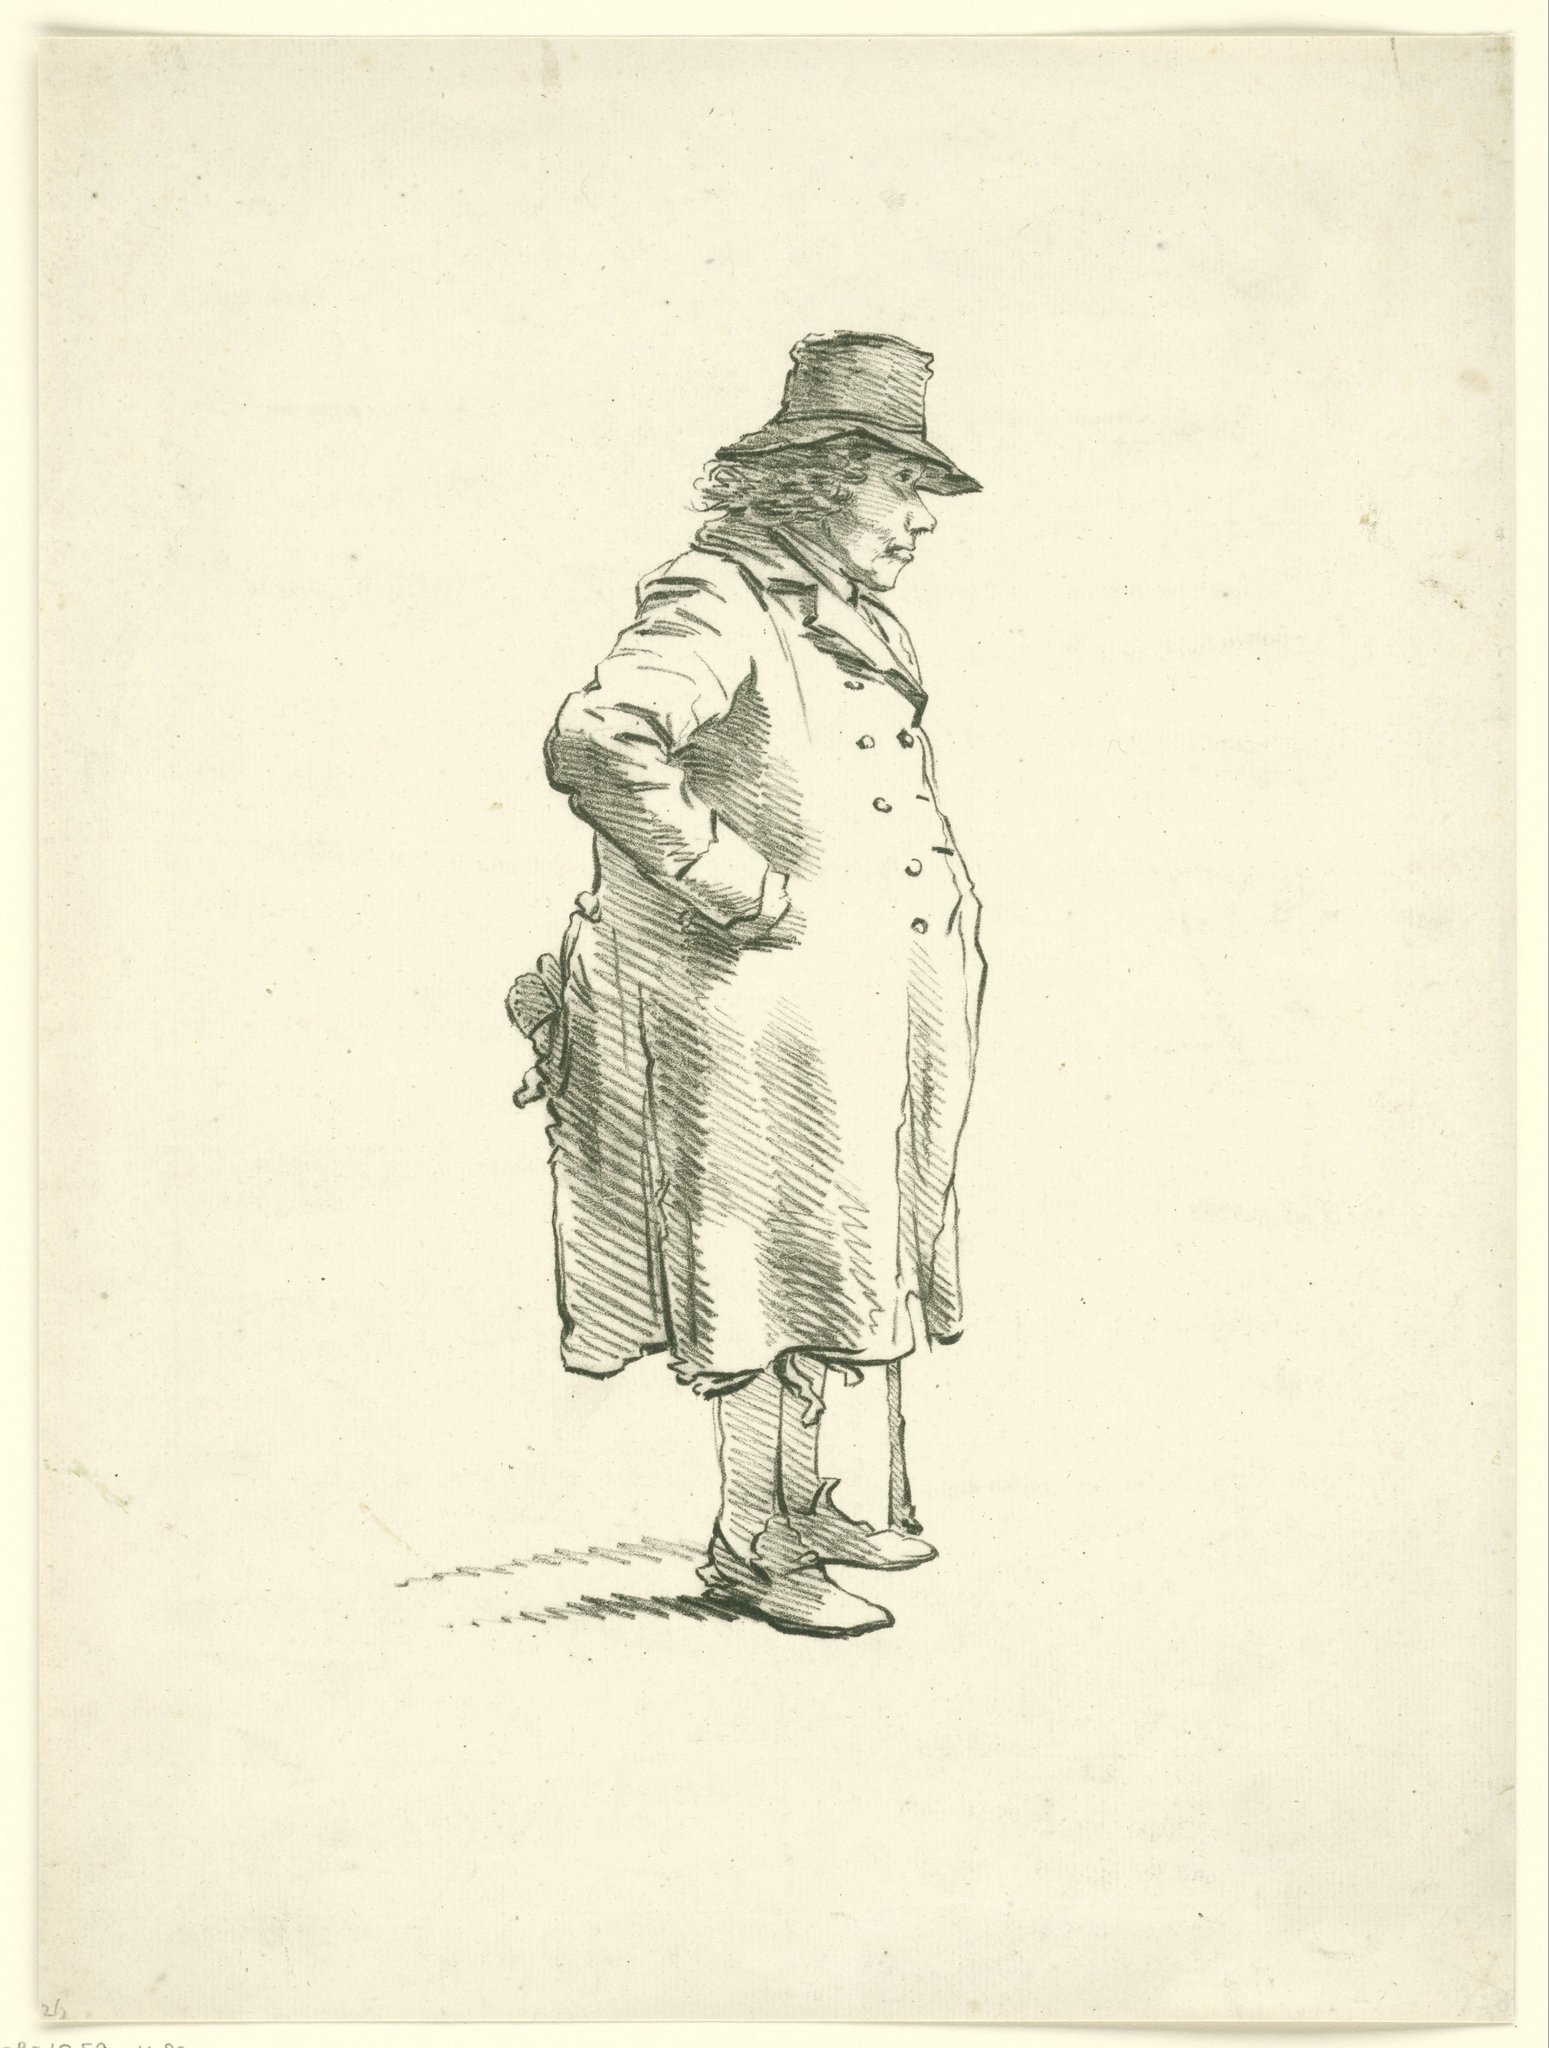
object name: print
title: Portrait of the beggar Hendrik Delbroeck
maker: hendrik van der burgh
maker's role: draughtsman, print maker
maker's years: 1769-1858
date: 1809-1858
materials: paper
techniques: lithograph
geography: the hague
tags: clothed in rags, beggar, historical persons (+ full length portrait)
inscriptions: collector's mark: Lugt 2228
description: De man, ten voeten uit afgebeeld, draagt een kapotte lange jas en hoed. Hij kijkt naar rechts en heeft zijn rechterhand in zijn zak gestoken. Uit zijn achterzak steekt een schoen.